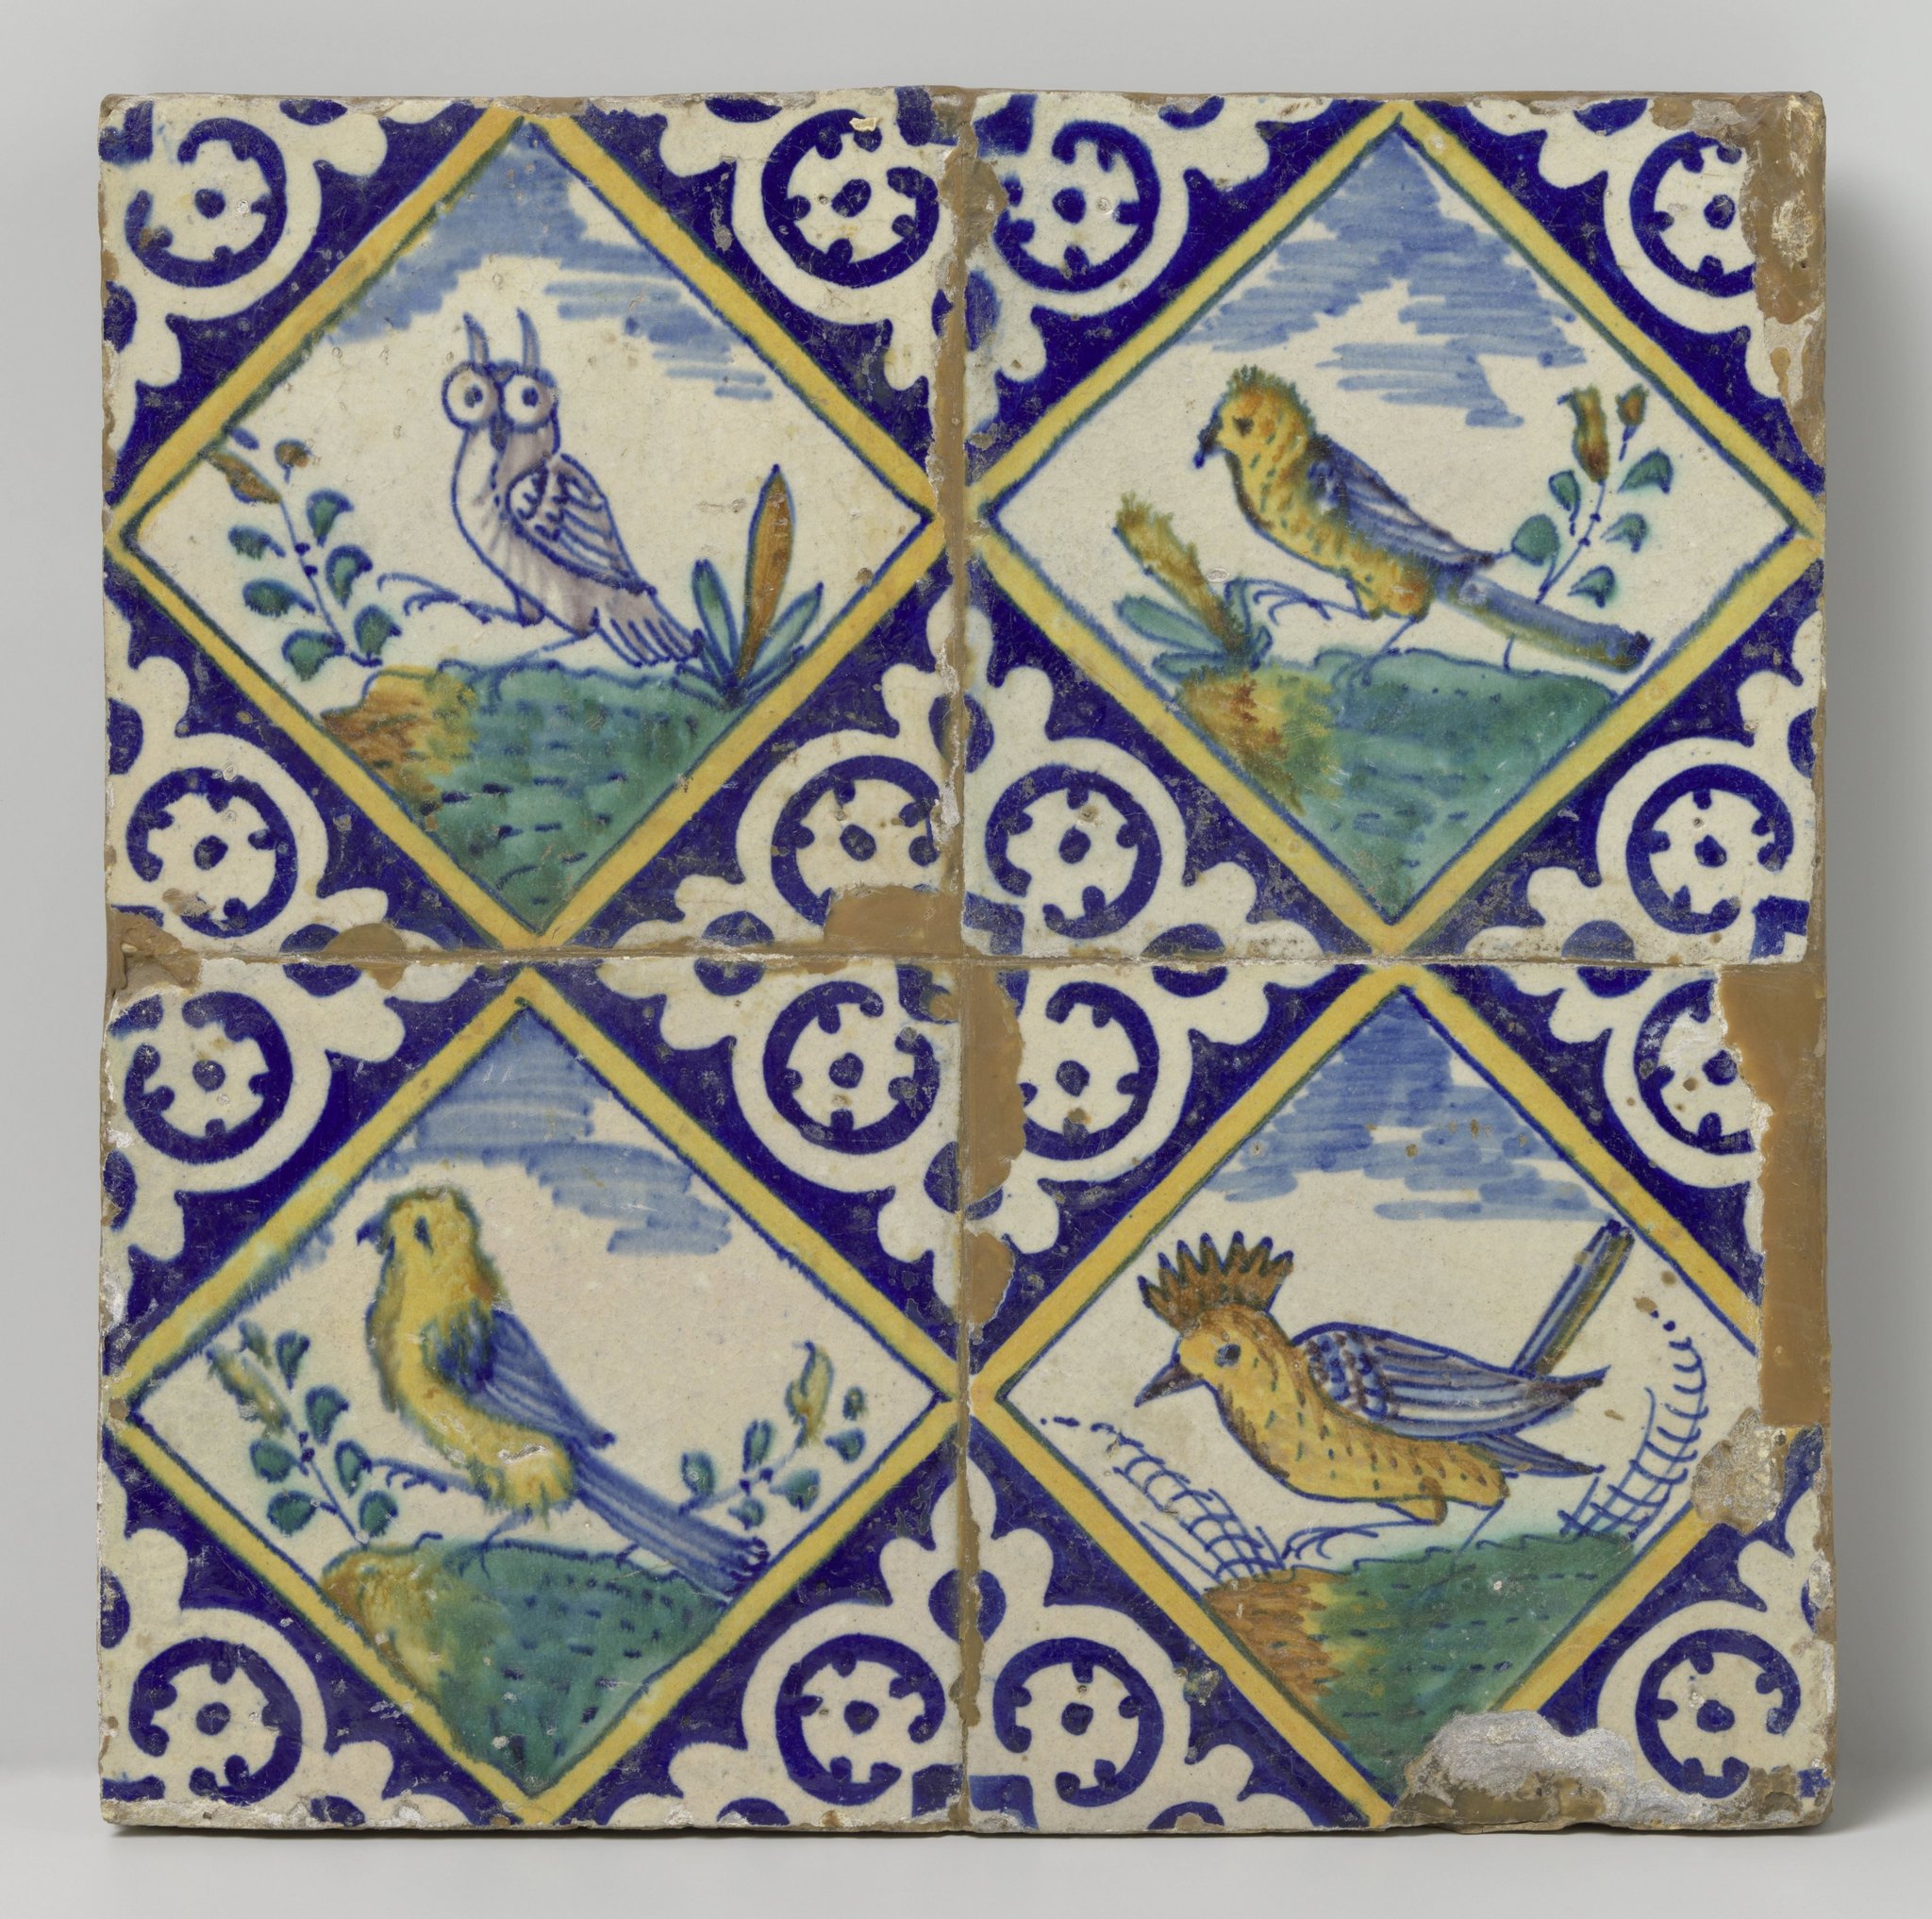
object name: tegelveld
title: Veld van vier tegels met vogels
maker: Anonymous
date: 1580-1625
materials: earthenware, glaze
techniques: maiolica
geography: netherlands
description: Veld van vier tegels (2 x 2) elk met een veelkleurige (blauw, oranje, geel, groen en paars) vogel op een grond binnen een kwadraat. In de hoeken, ornament in vultechniek.